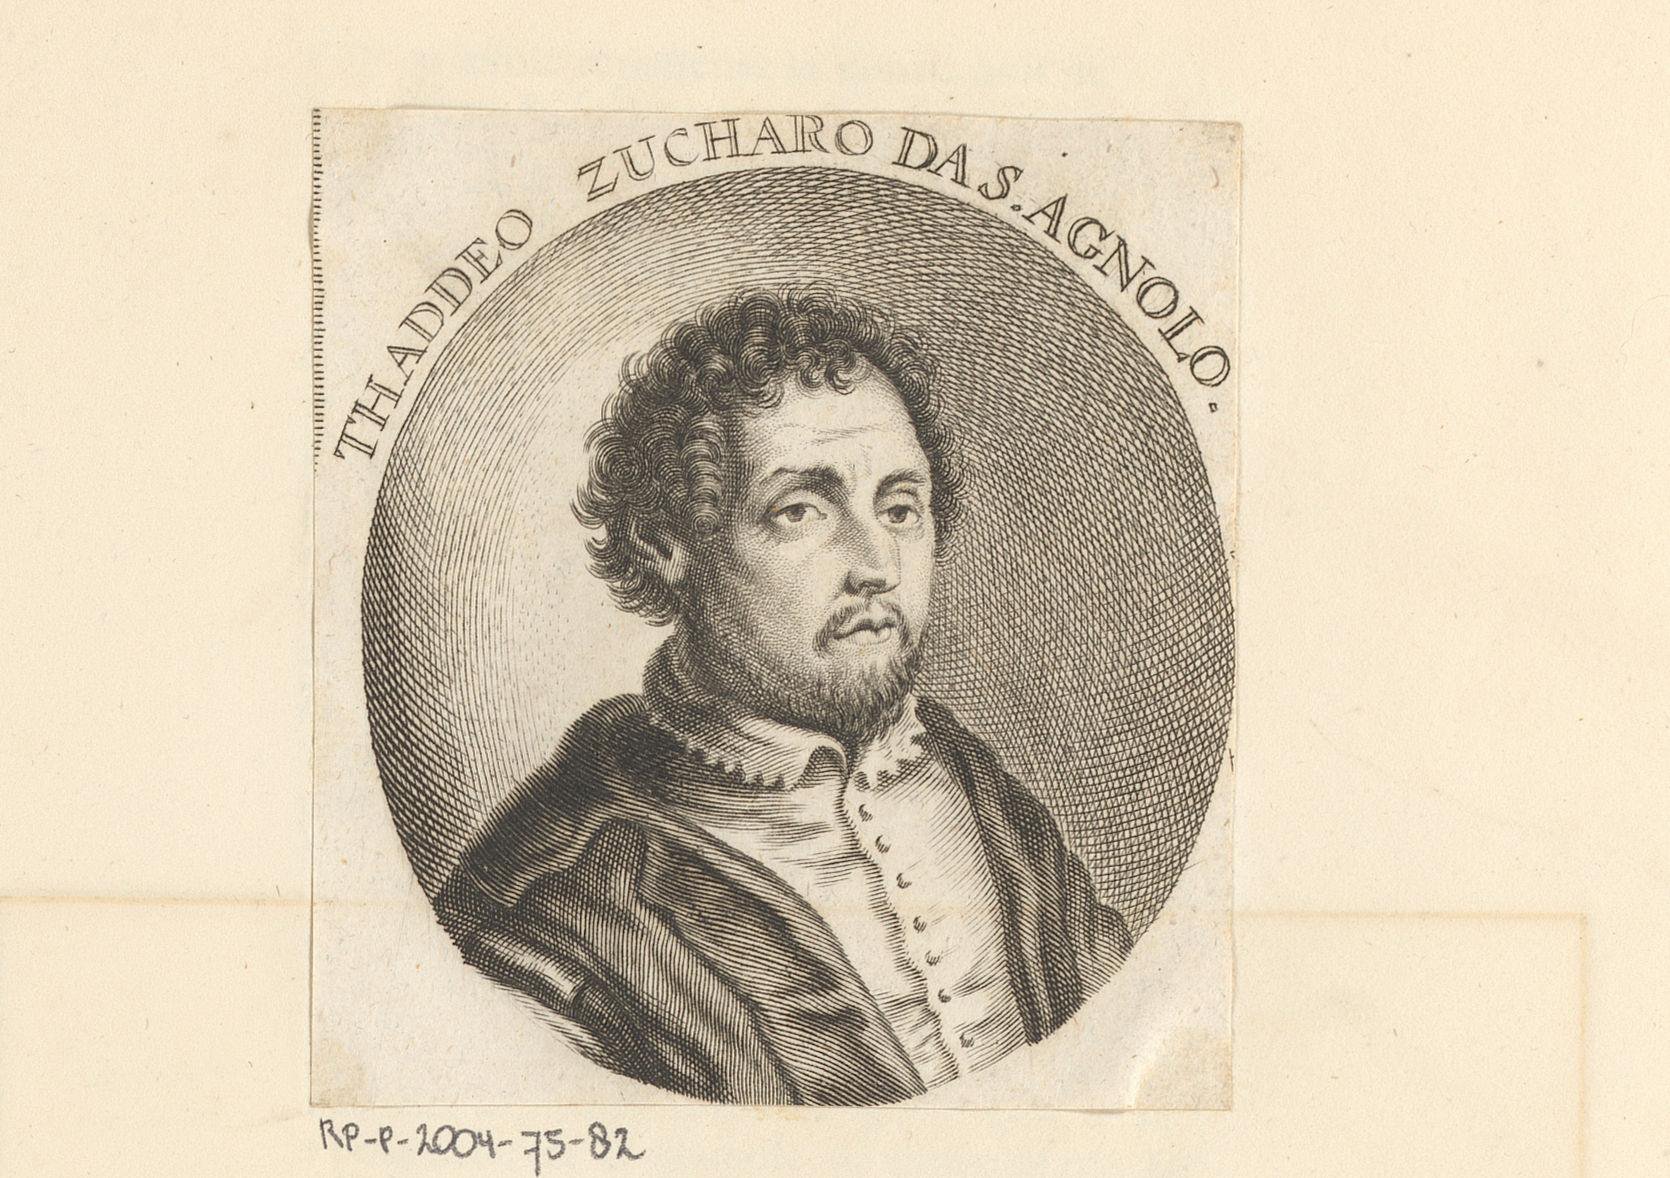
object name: print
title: Portret van Taddeo Zuccaro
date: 1675-1679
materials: paper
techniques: engraving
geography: nuremberg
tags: draughtsman, taddeo zuccaro, historical persons, portrait, self-portrait of painter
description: Prent mogelijk uit: Sandrart, Joachim. Teutsche Academie der Edlen Bau- Bild- und Mahlerey-Künste (...). Neurenberg: Jakob von Sandrart, [1675-1679]. Latere staat van de prent gebruikt in: Sandrart, Joachim von. Teutsche Academie der Bau- Bildhauer- und Maler-Kunst: worinn die Regeln und Lehrsätze dieser Künste gegeben. 14 dln. Neurenberg: erven Johann Andreas Endter, [1774], dl. 7, p. Q. De samensteller heeft deze prent in het album geplakt als illustratie bij: Pilkington, Matthew en Johann Heinrich Füssli. A dictionary of painters, from the revival of the art to the present period. 4 dln. Londen: John Crowder, 1805, dl. 4, p. 664.